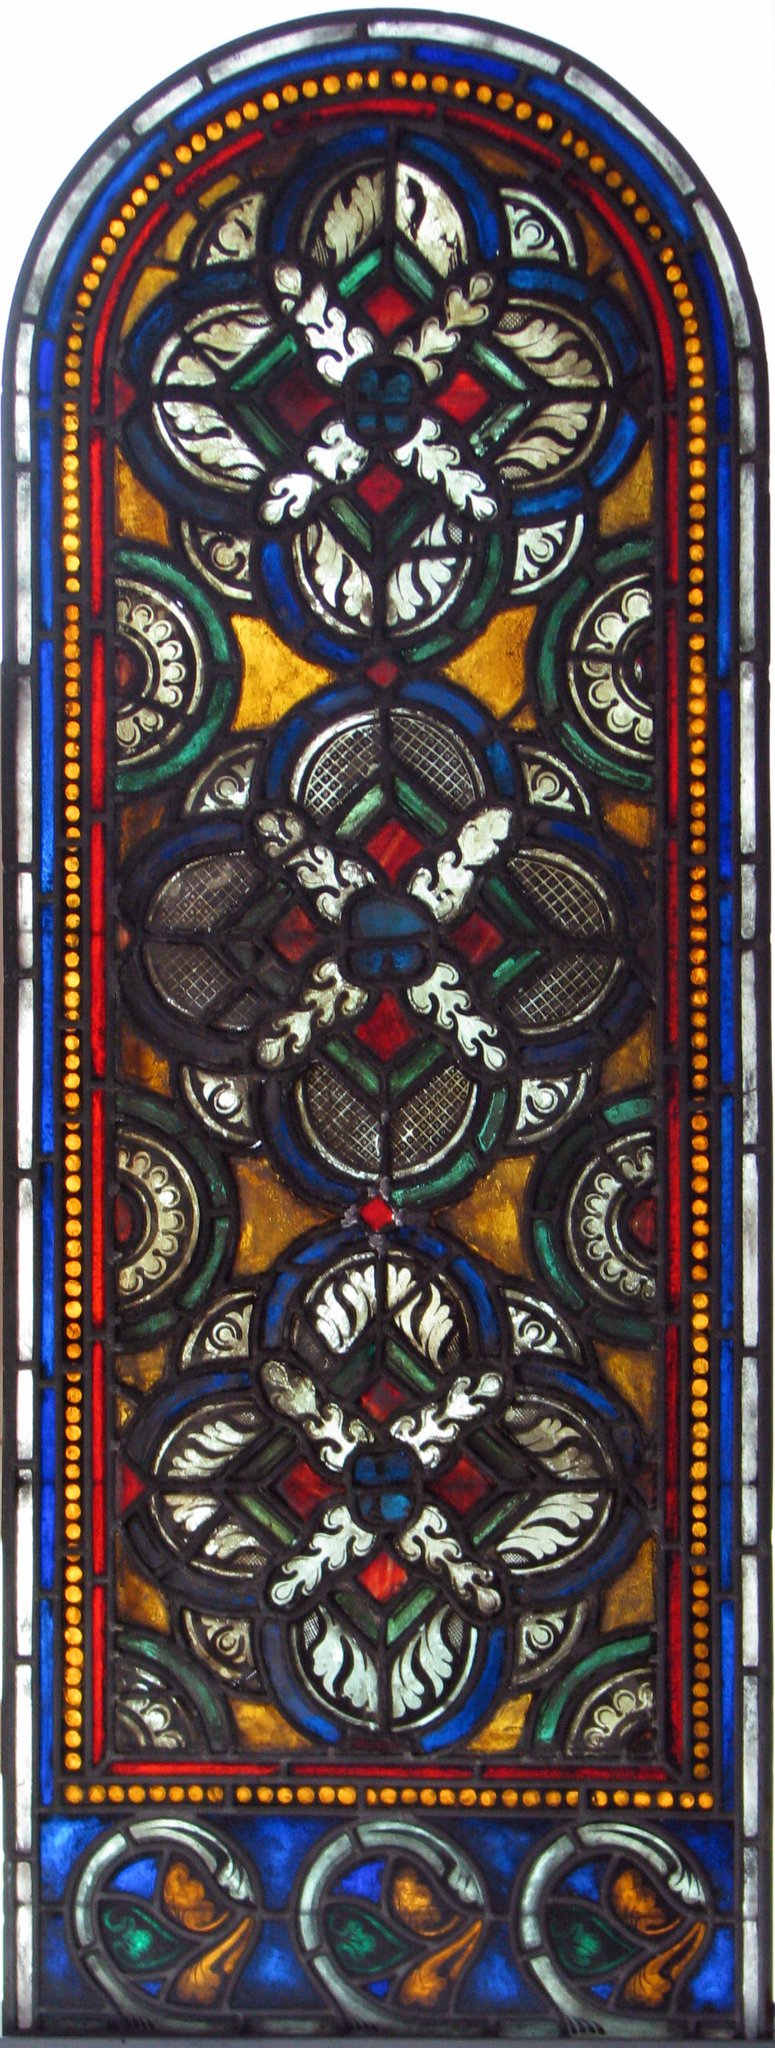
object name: panel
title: Ornamental Window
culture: french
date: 1180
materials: glass, metal, paint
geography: france